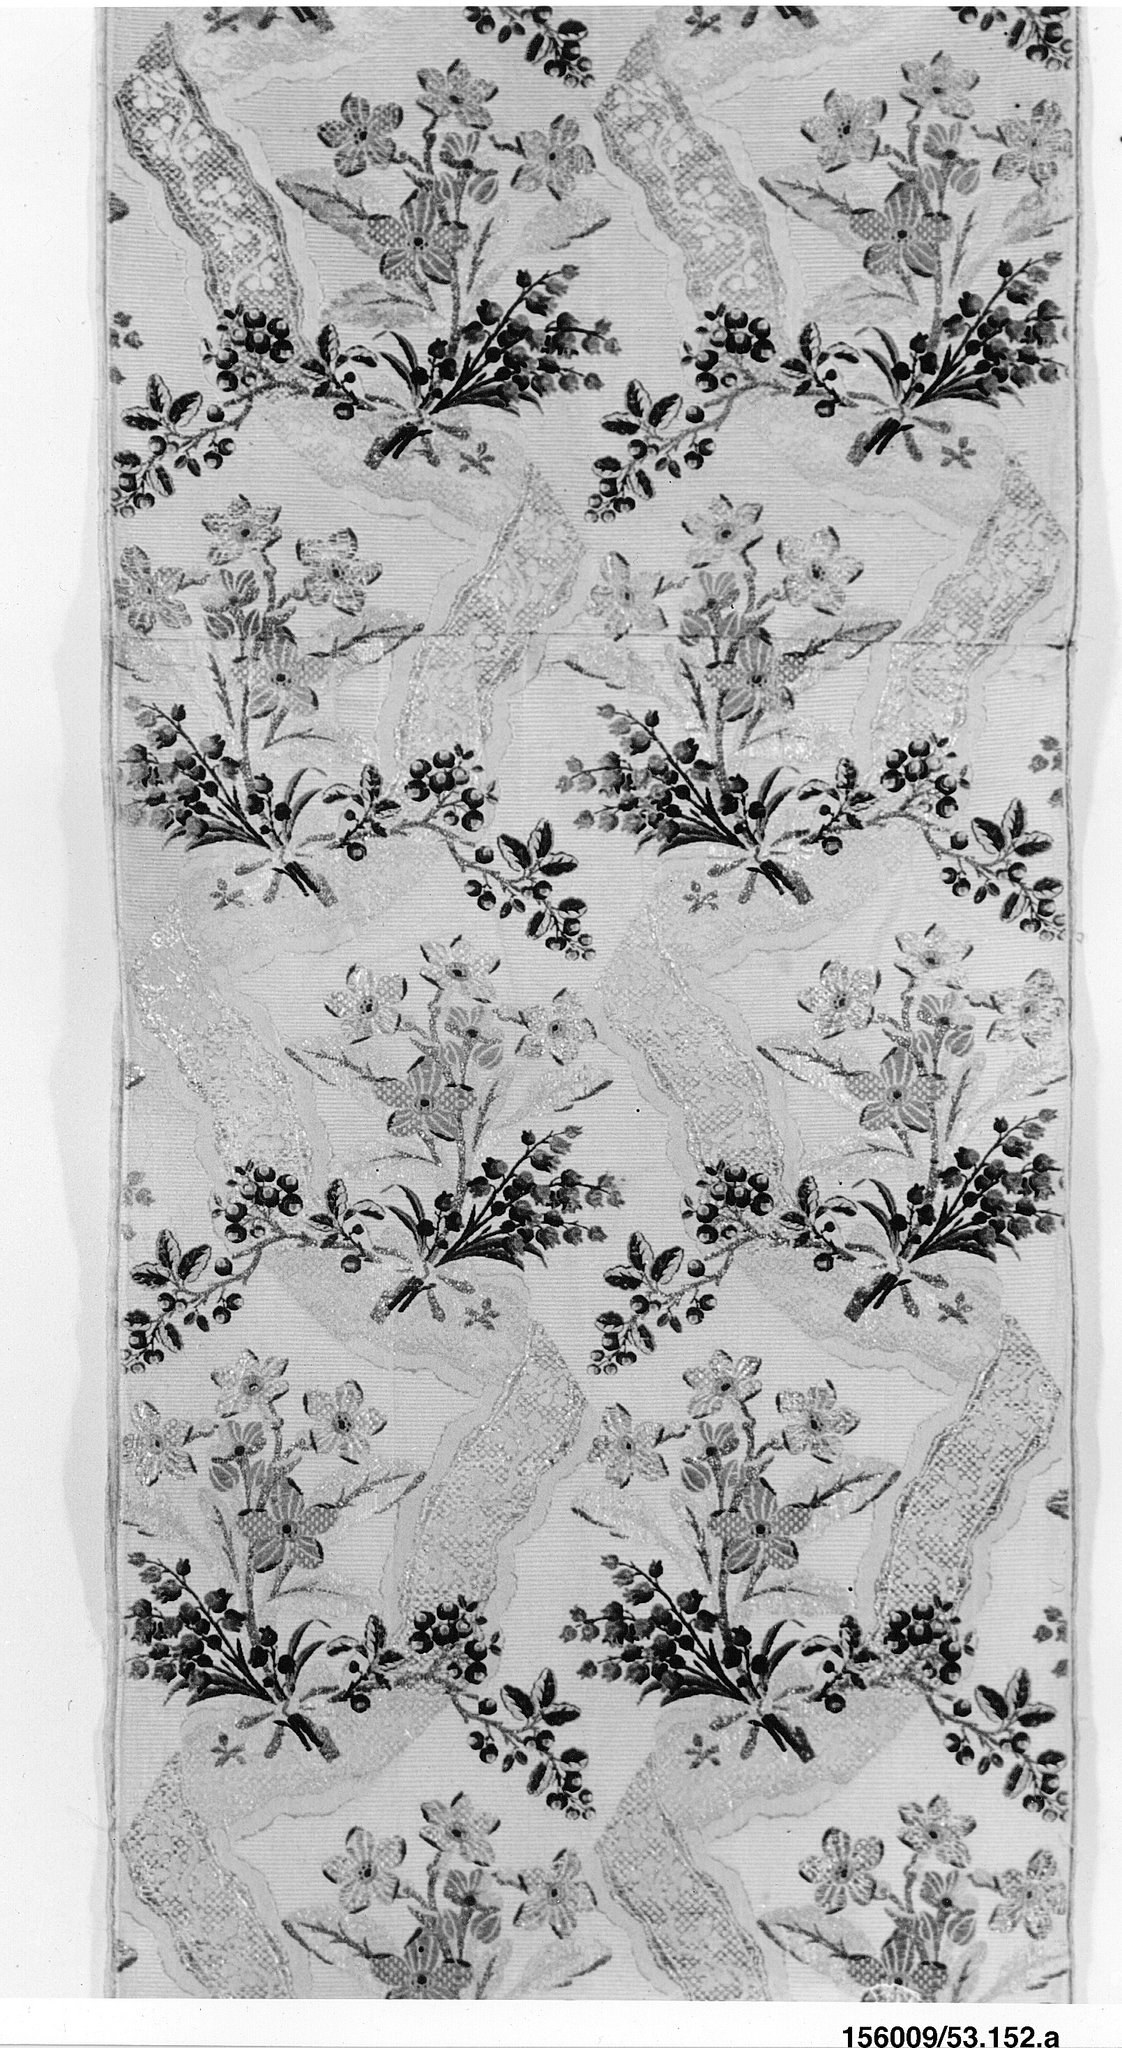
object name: piece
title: Pieces (2)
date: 1750-1760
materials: metal thread, silk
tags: flowers,leaves